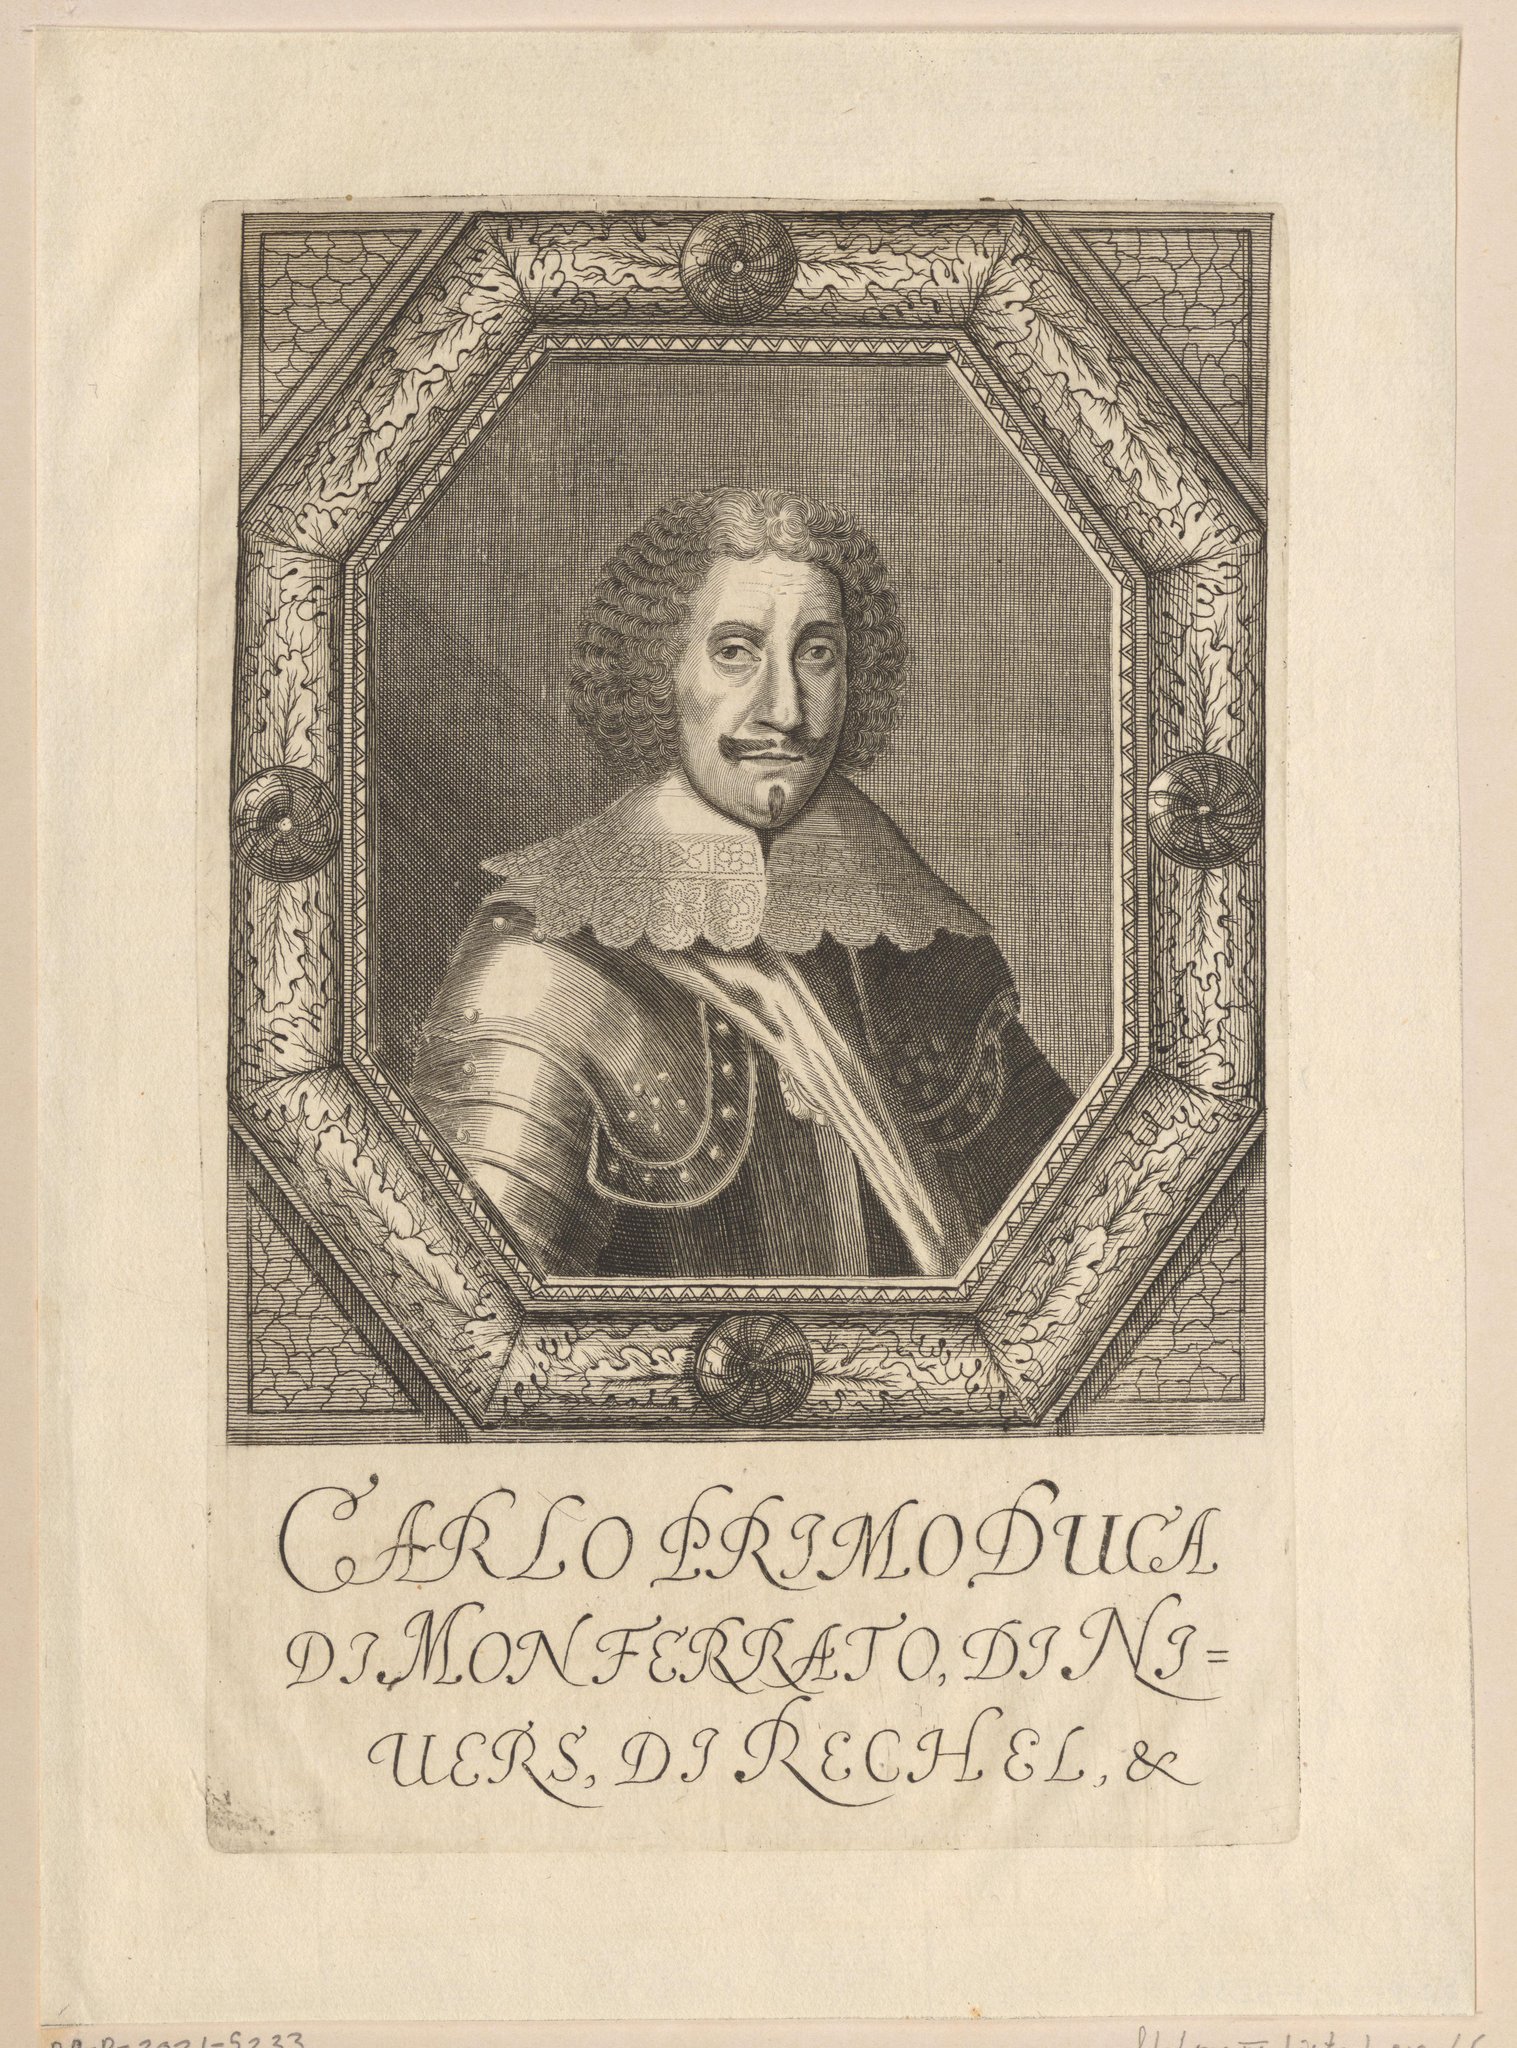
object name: print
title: Portret van Carlo I Gonzaga, hertog van Mantua en Montferrat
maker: Anonymous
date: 1650-1749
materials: paper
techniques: engraving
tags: historical persons, nobility and patriciate; chivalry, knighthood